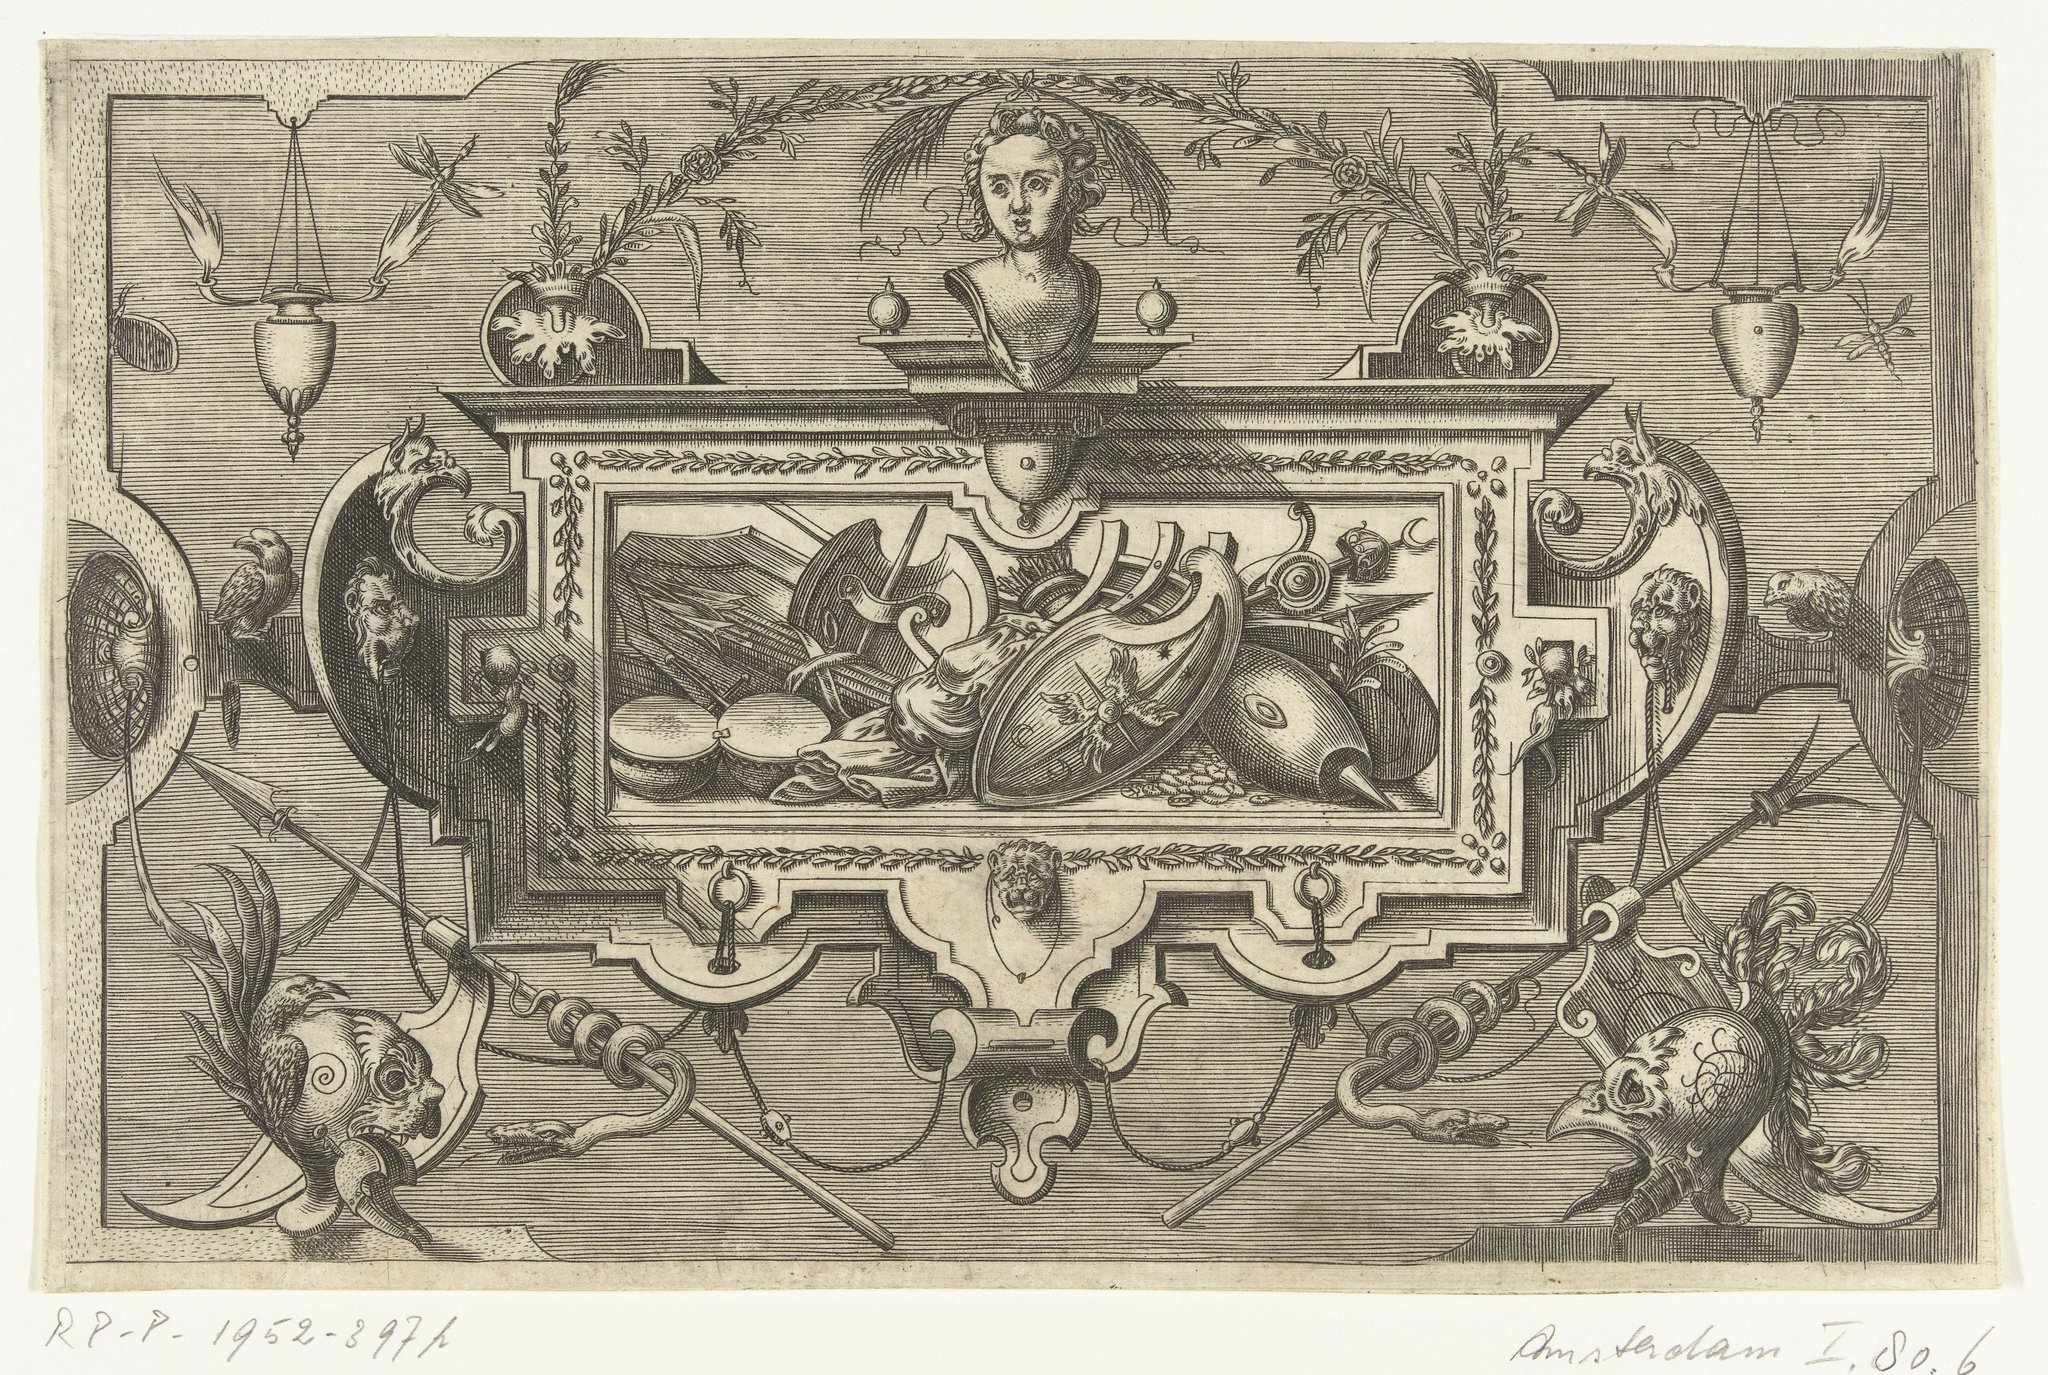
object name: print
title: Veelderhande cierlijcke compertementen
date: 1564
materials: paper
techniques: engraving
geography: antwerp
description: Op de cartouche staat in het midden het borstbeeld van een vrouw. Gearceerde achtergrond. Onderdeel van serie met titelblad en 12 bladen.